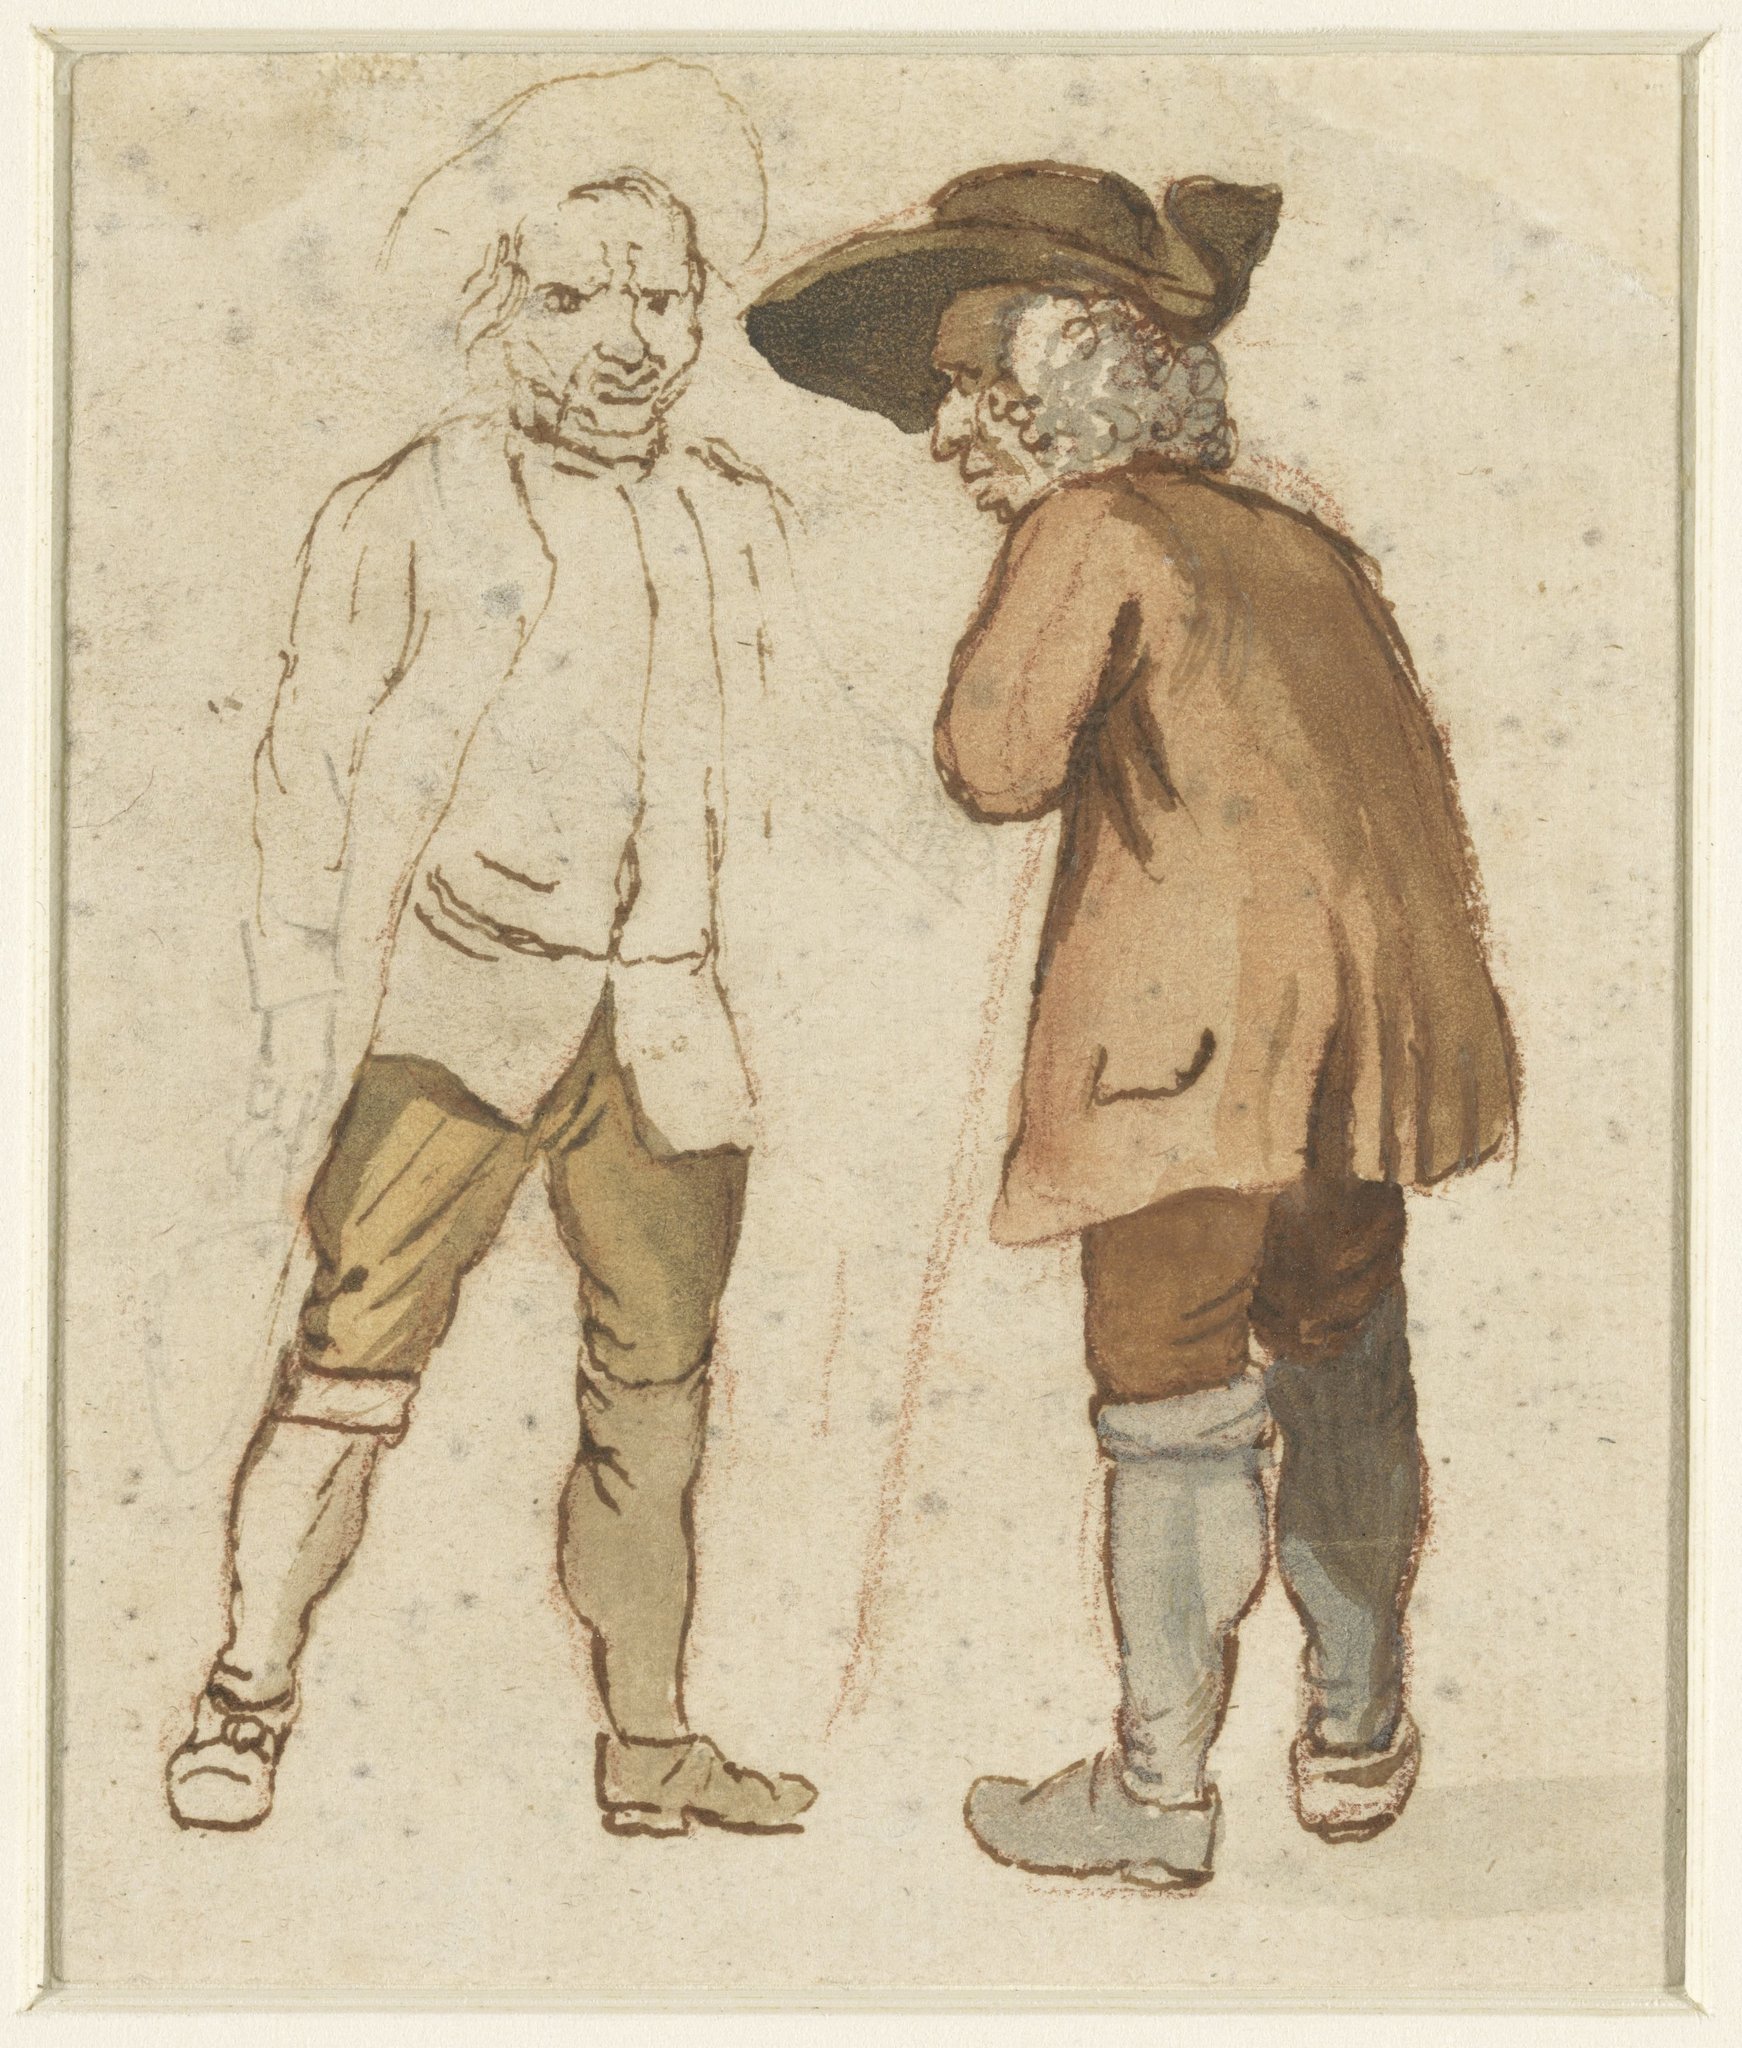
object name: drawing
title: Twee oude boeren in gesprek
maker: elias martin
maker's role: draughtsman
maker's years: 1739-1818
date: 1749-1818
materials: chalk, ink, paper, pencil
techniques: brush, pen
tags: child, farmers